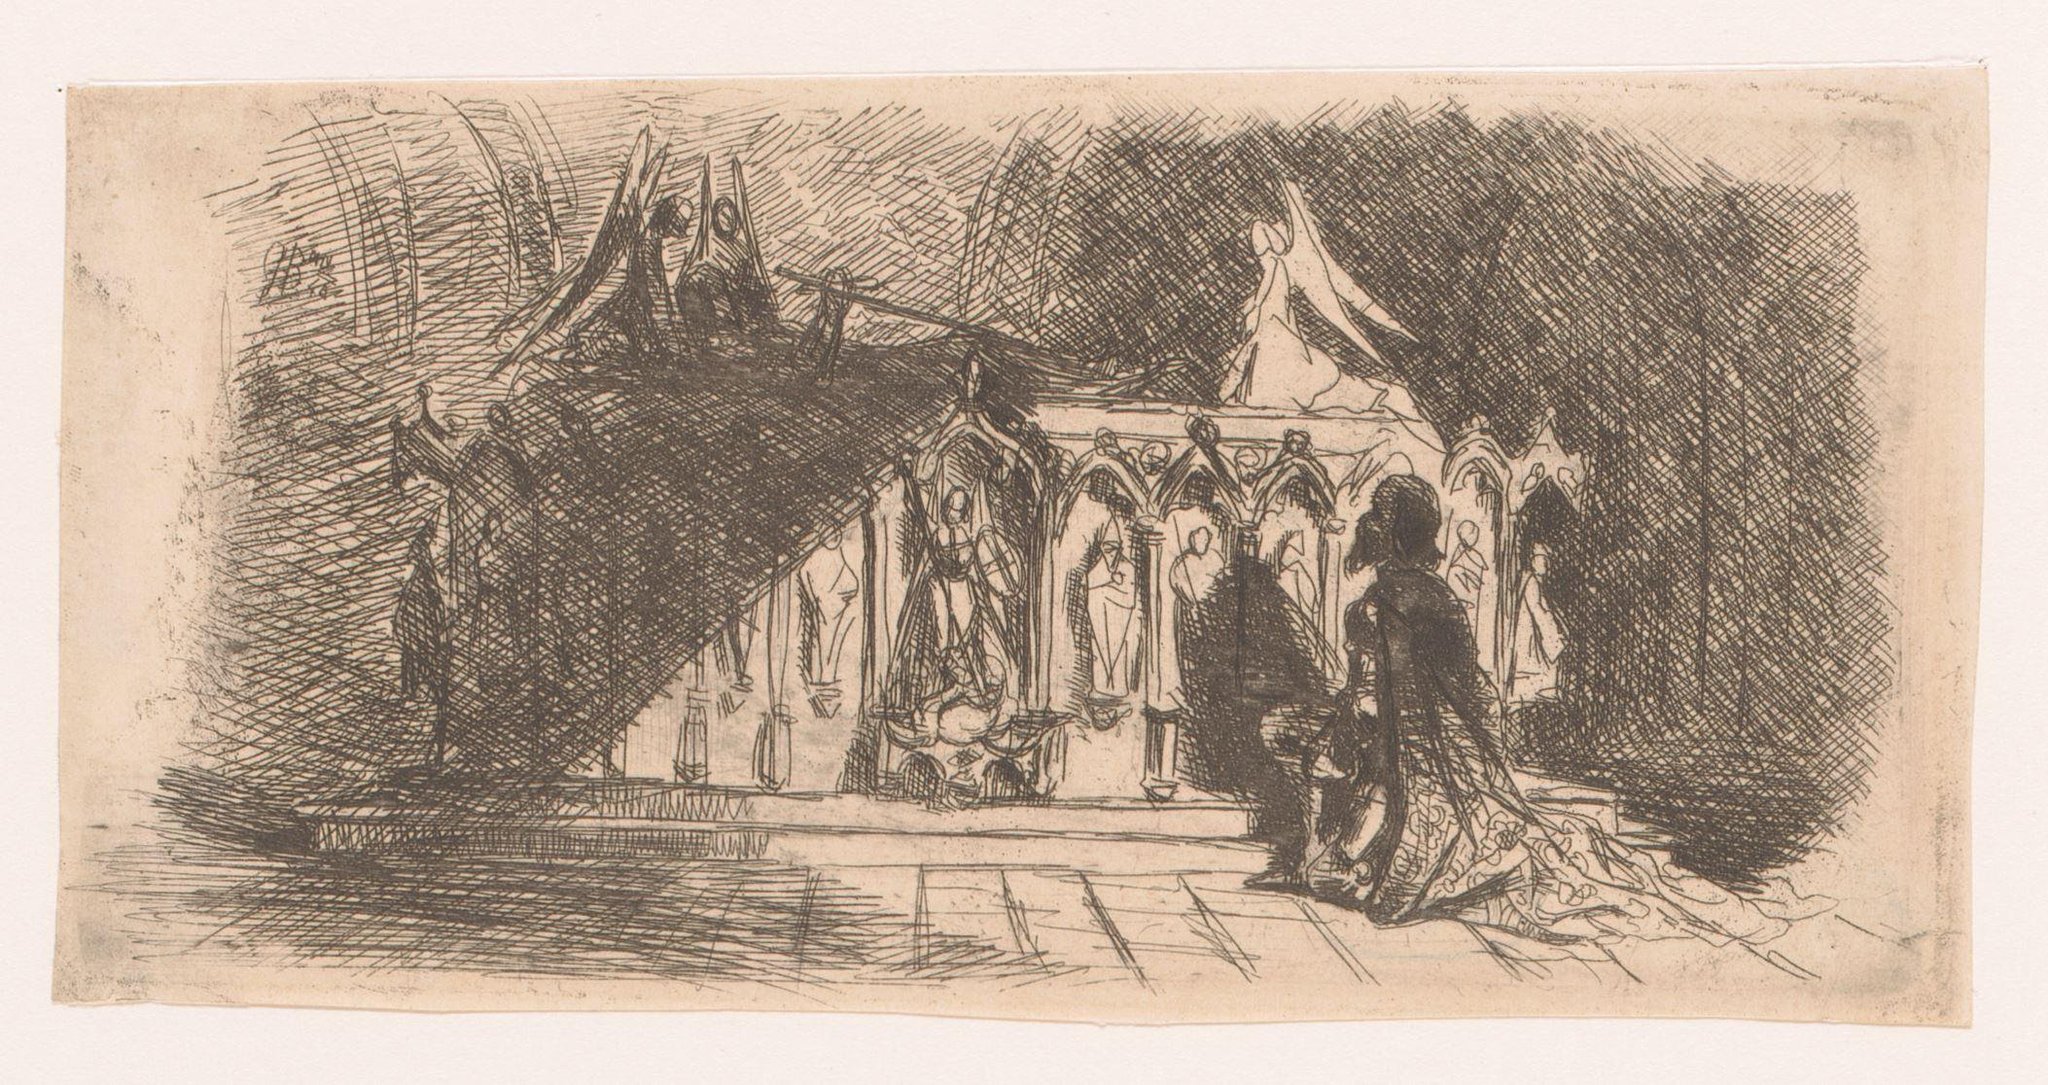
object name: print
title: Man knielt voor een gotische graftombe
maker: gustave buschmann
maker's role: print maker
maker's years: 1818-1852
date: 1840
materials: paper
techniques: etching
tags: grave, tomb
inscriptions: collector's mark: Lugt 2228